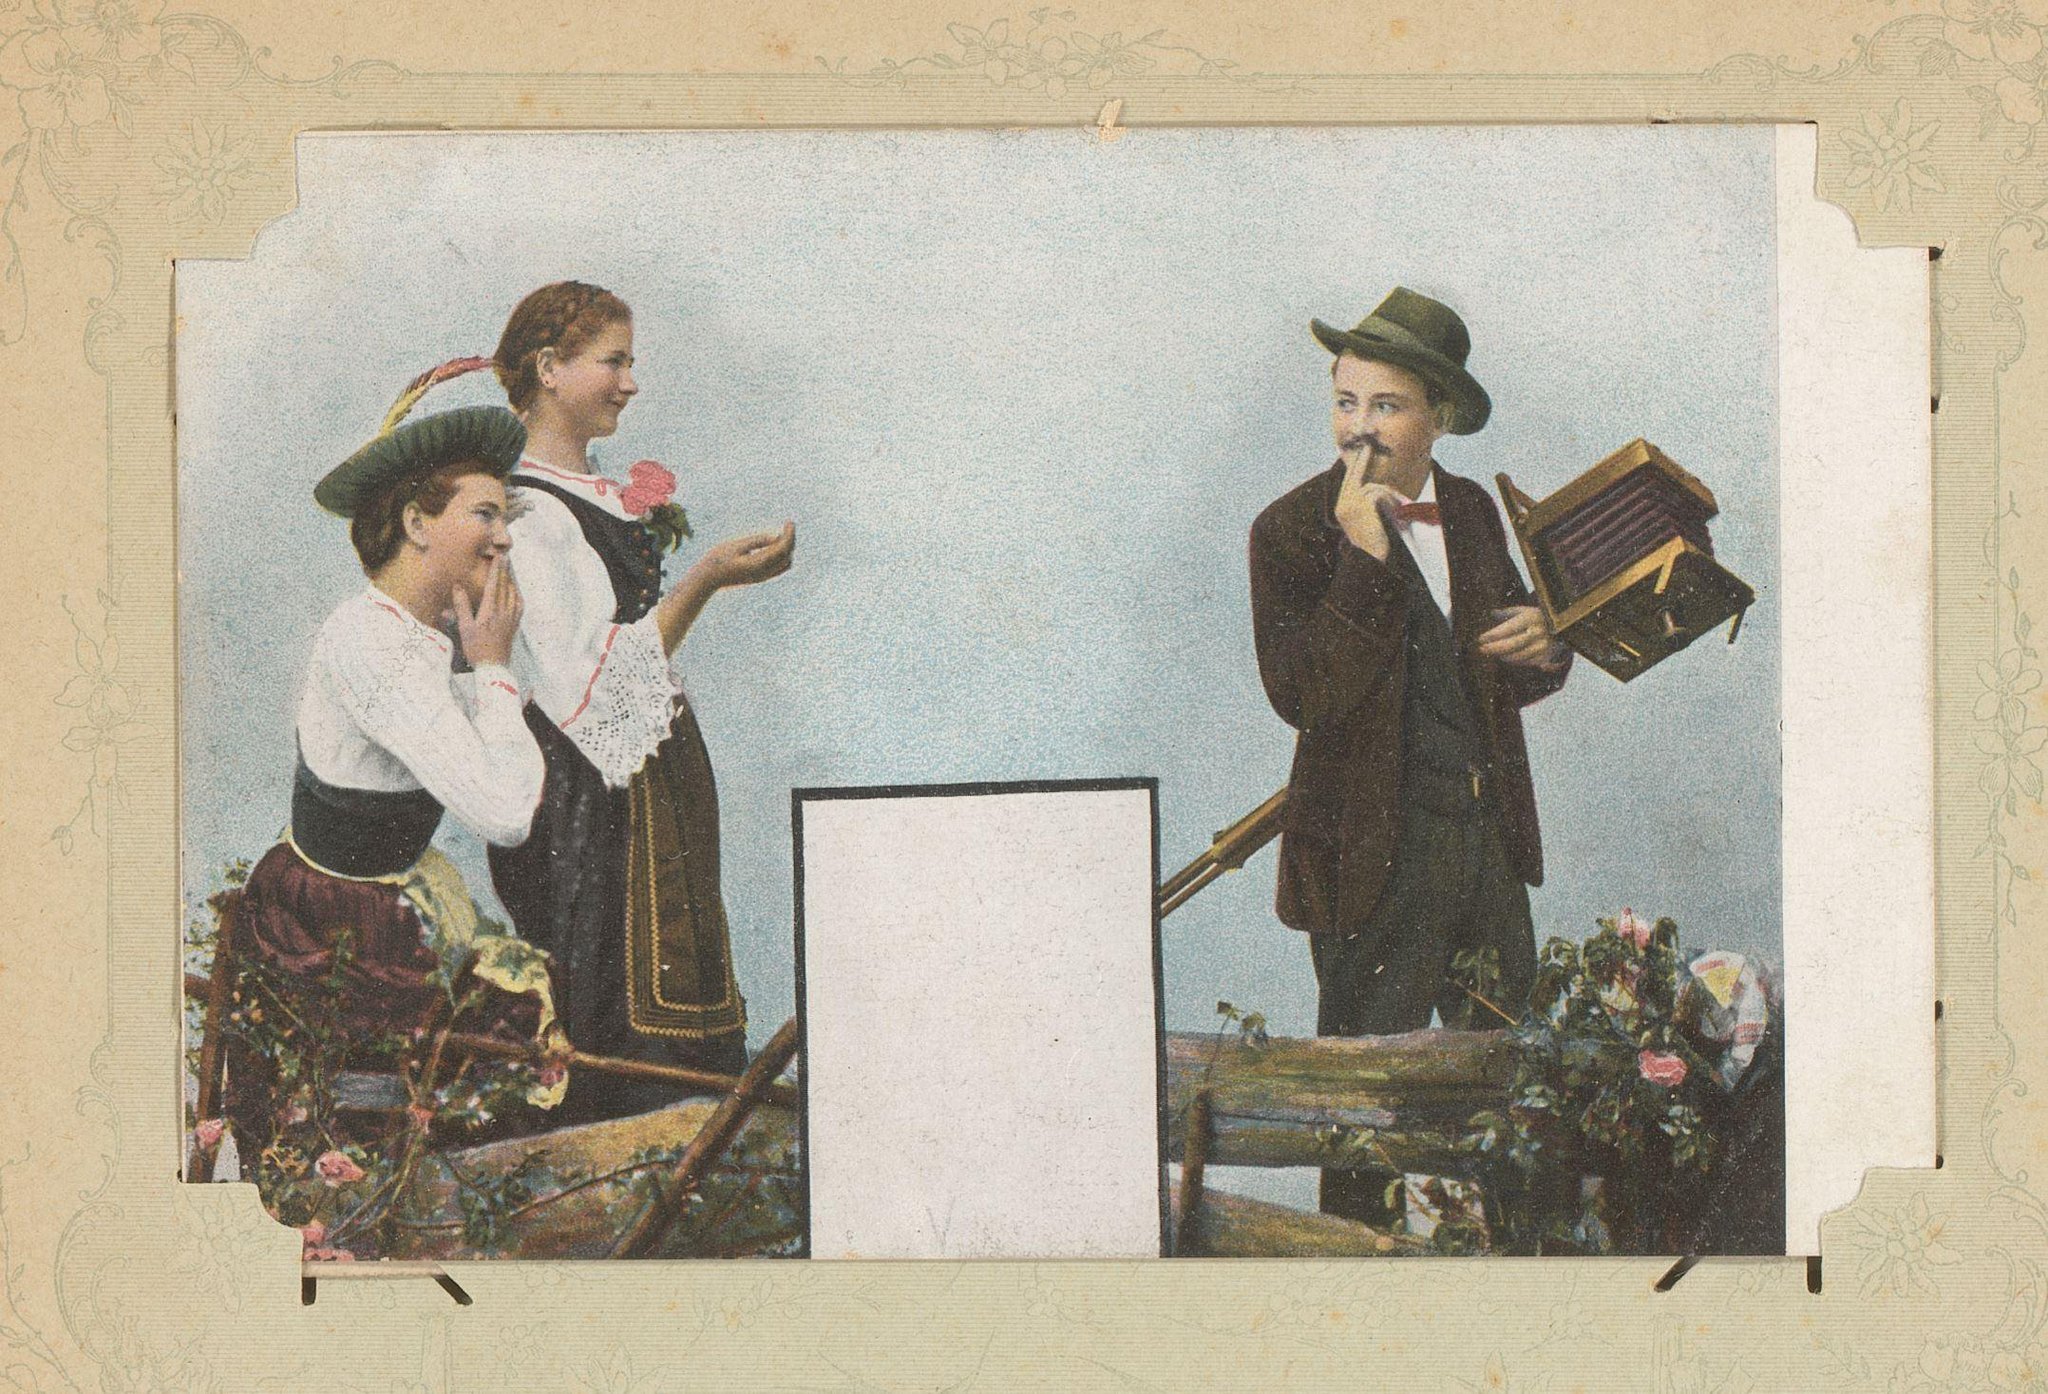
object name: photomechanical print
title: Twee vrouwen en een man met een camera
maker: Anonymous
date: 1900-1950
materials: cardboard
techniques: four-color autotype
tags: flowers, adult woman, photography, adult man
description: Deze prent maakt deel uit van een album.